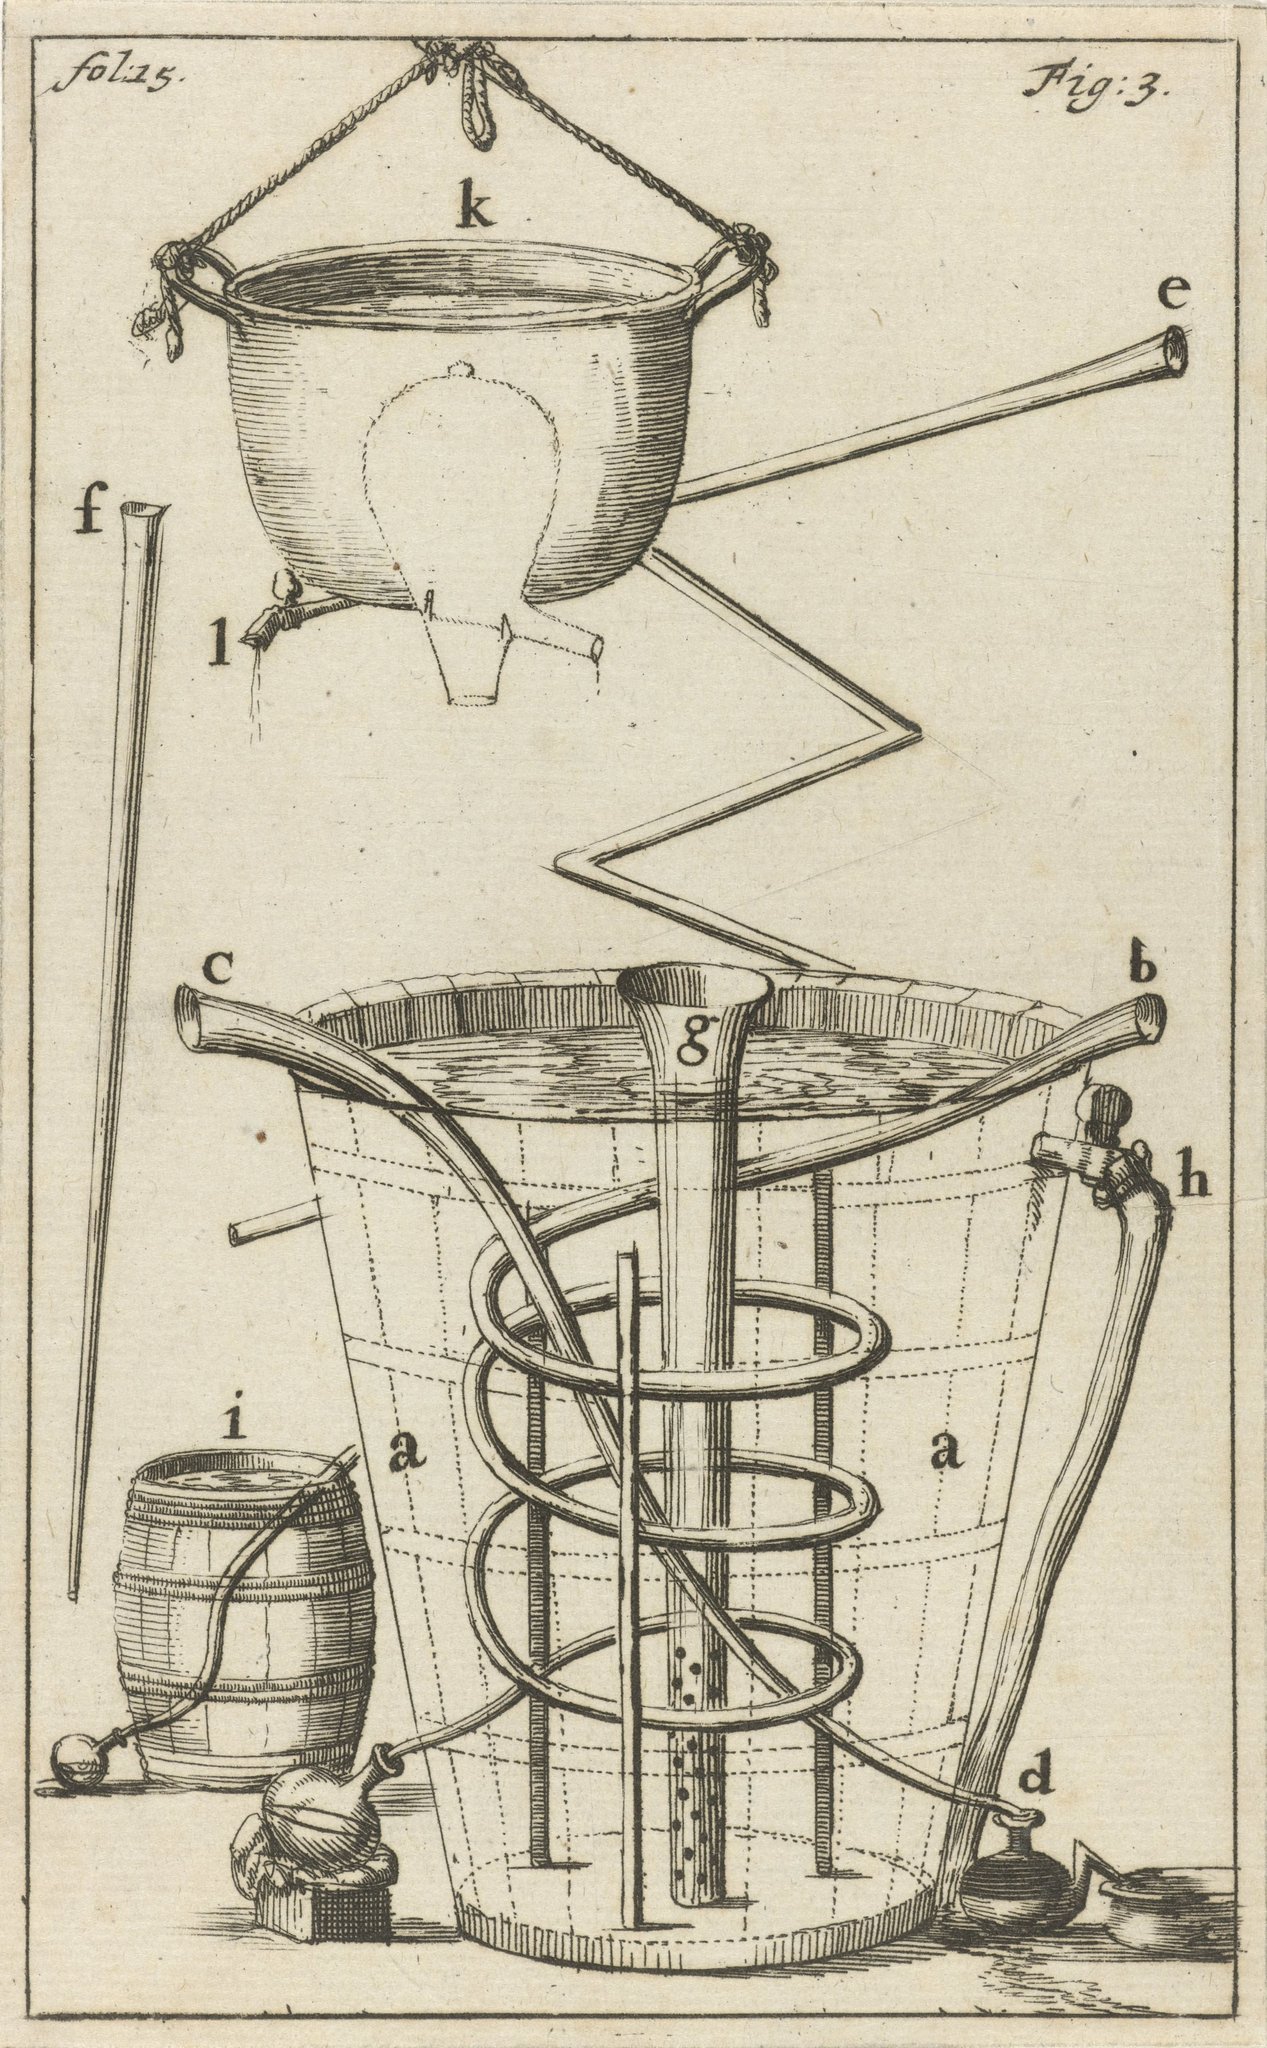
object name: print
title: Distilleertoestel met aanduidingen A-K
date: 1689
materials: paper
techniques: etching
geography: amsterdam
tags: laboratory (+ tools, instruments; laboratory equipment ~ scientific research), pharmacy, pharmaceutics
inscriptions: collector's mark: Lugt 2228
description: Illustratie uit: Halmaal, Jacob van. Ontleding over d'Amsterdamsche apotheek. Amsterdam: Jan Claesz ten Hoorn, 1689.